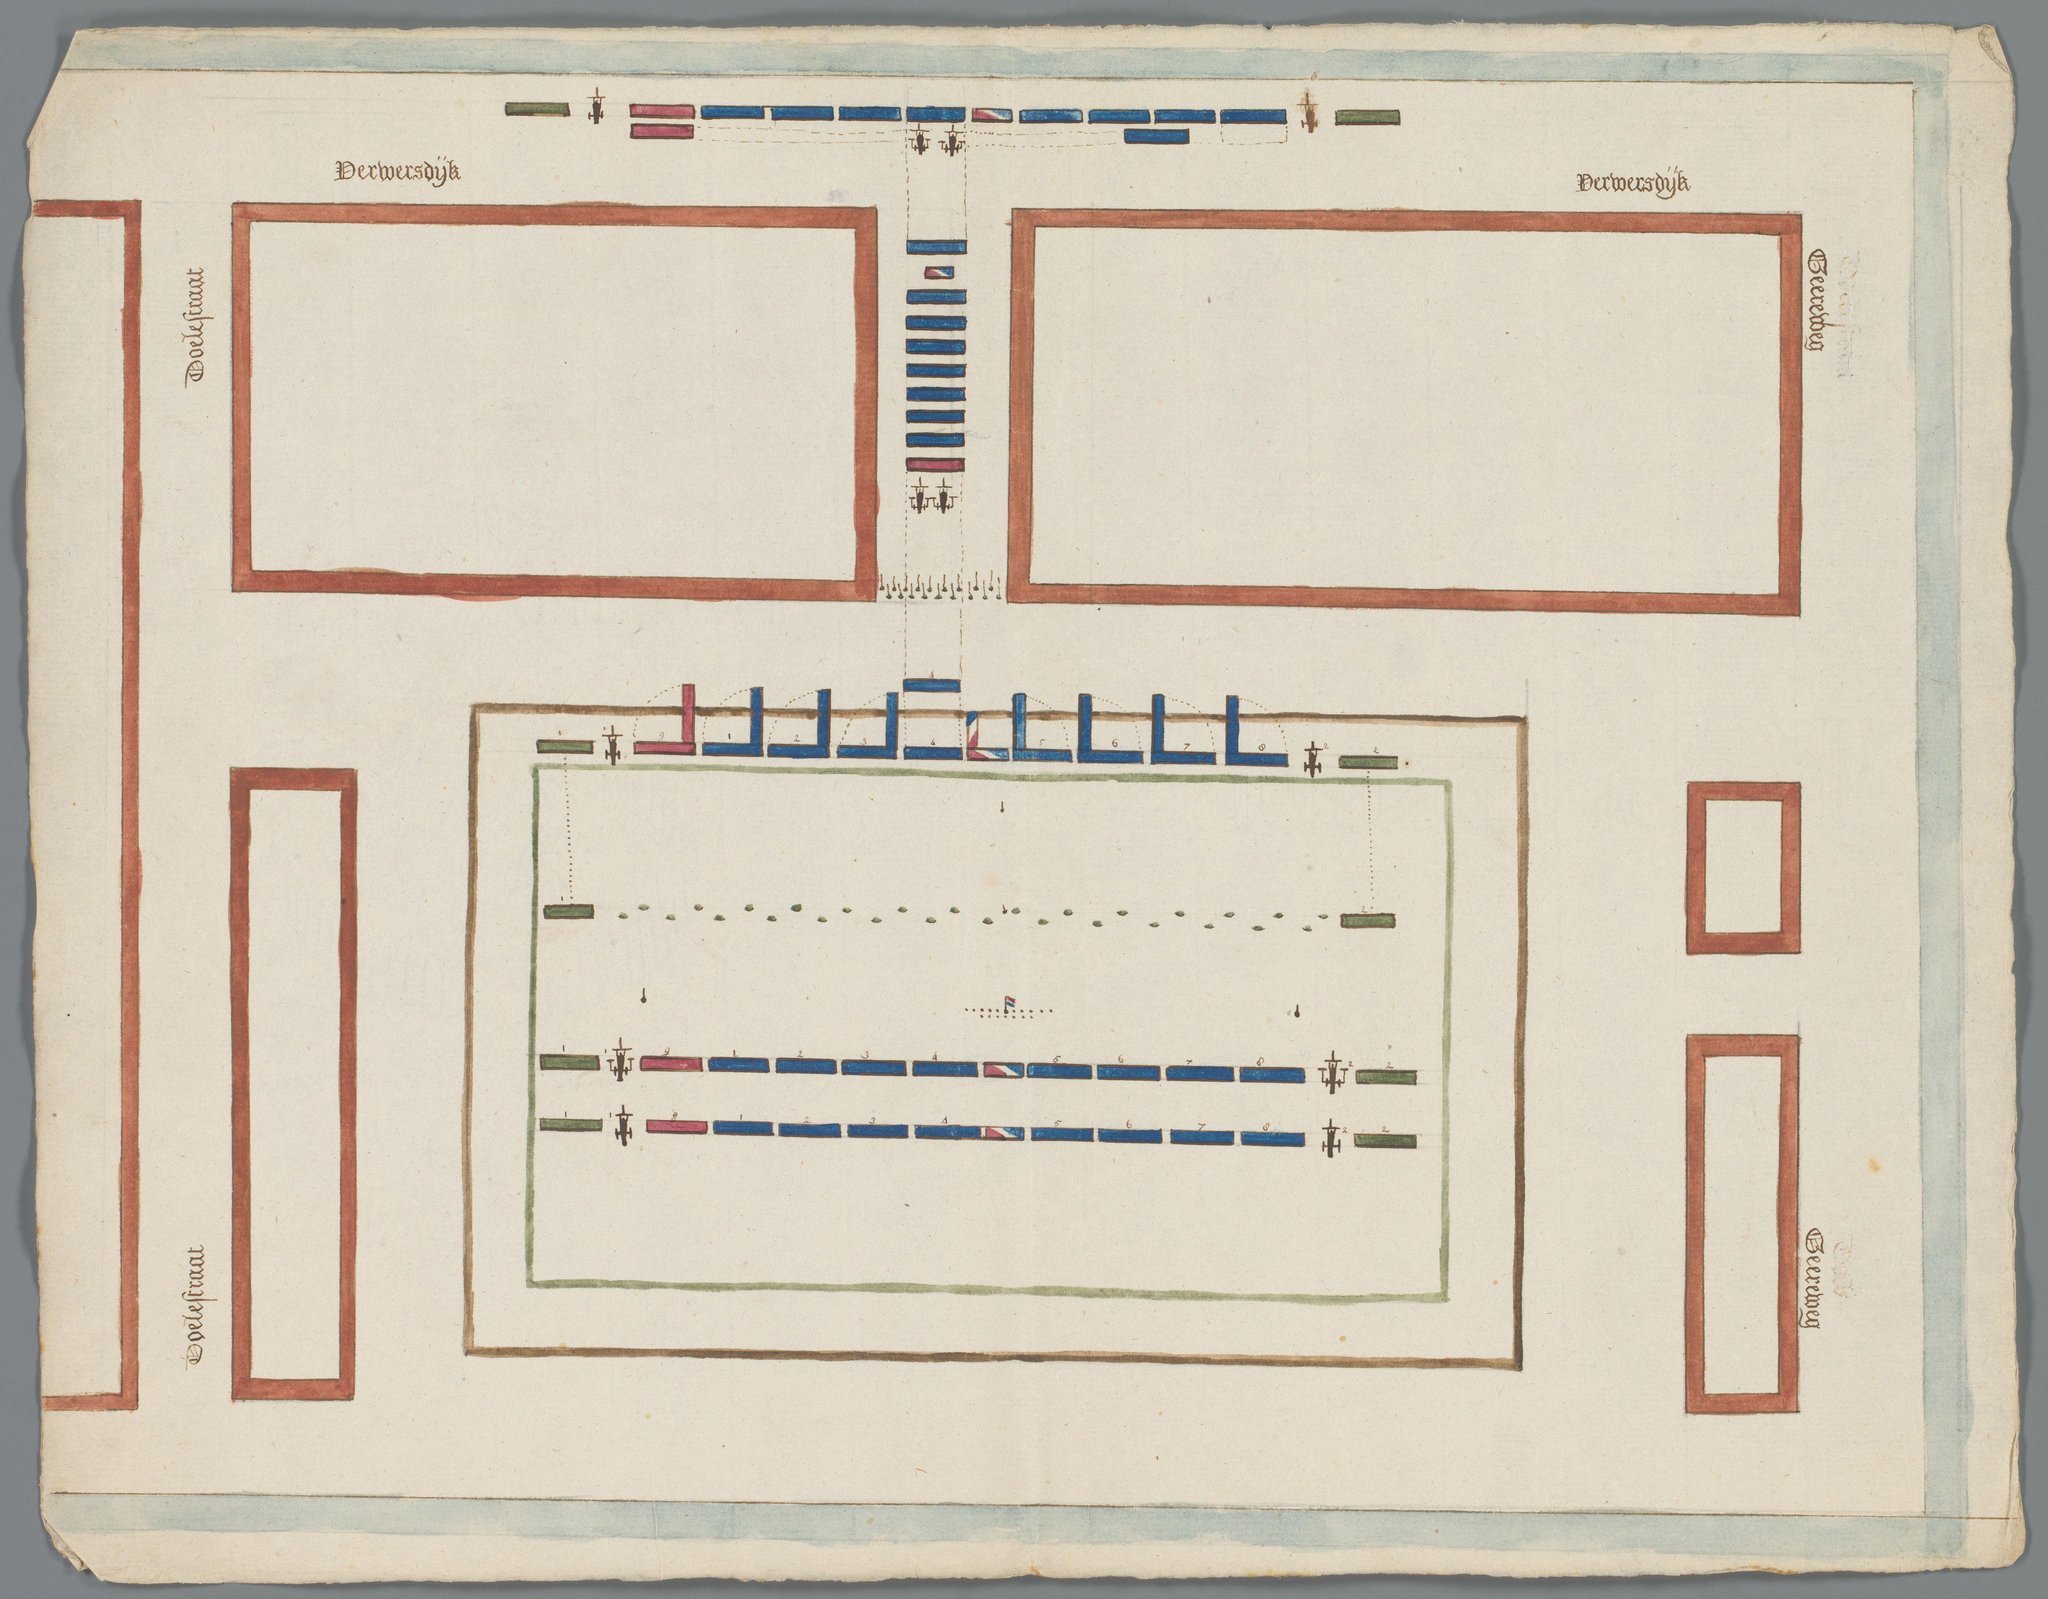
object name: drawing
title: Plattegrond met manoeuvres op het Schuttersveld te Delft, ca. 1799-1803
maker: hendrik van der poth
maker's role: draughtsman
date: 1799-1803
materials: paper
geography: netherlands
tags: manoeuvre ~ military training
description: Plattegrond van de manoeuvres of evoluties van de troepen van de Gewapende Burgermacht op het Schuttersveld langs de Verwersdijk te Delft, ca. 1799-1803.